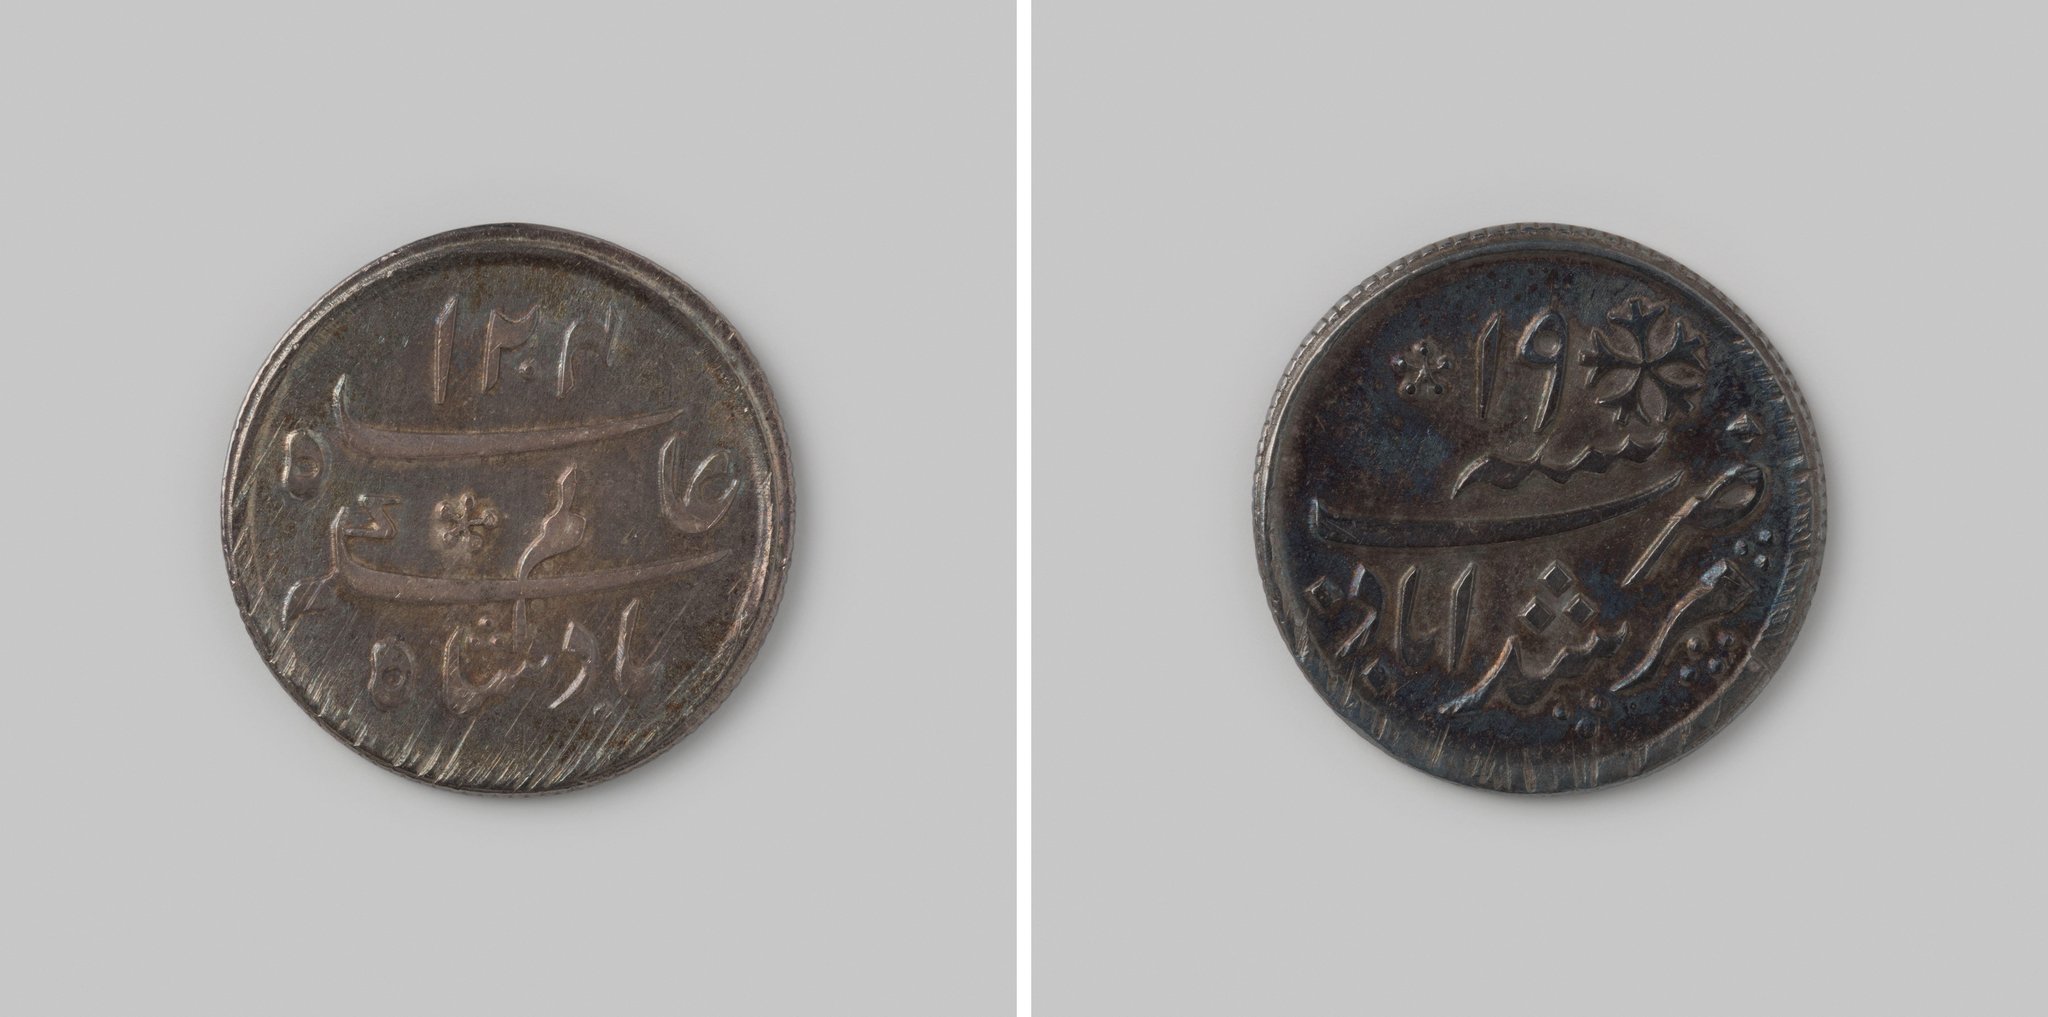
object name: coin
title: 1/4 roepie uit Bengalen in India van de Engelse Oostindische Compagnie (EIC) op naam van Sjah Alam I, 1202 [=1788] en regeringsjaar 19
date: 1788-1830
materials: silver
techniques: striking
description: Zilveren munt. Voorzijde: in Arabische lettertekens in twee regels opschrift. Bovenaan jaartal:1202 [=1788]. Keerzijde: in Arabische lettertekens in twee regels opschrift. Bovenaan aanduiding van het "eeuwige" regeringsjaar: 19. Kartelrand.